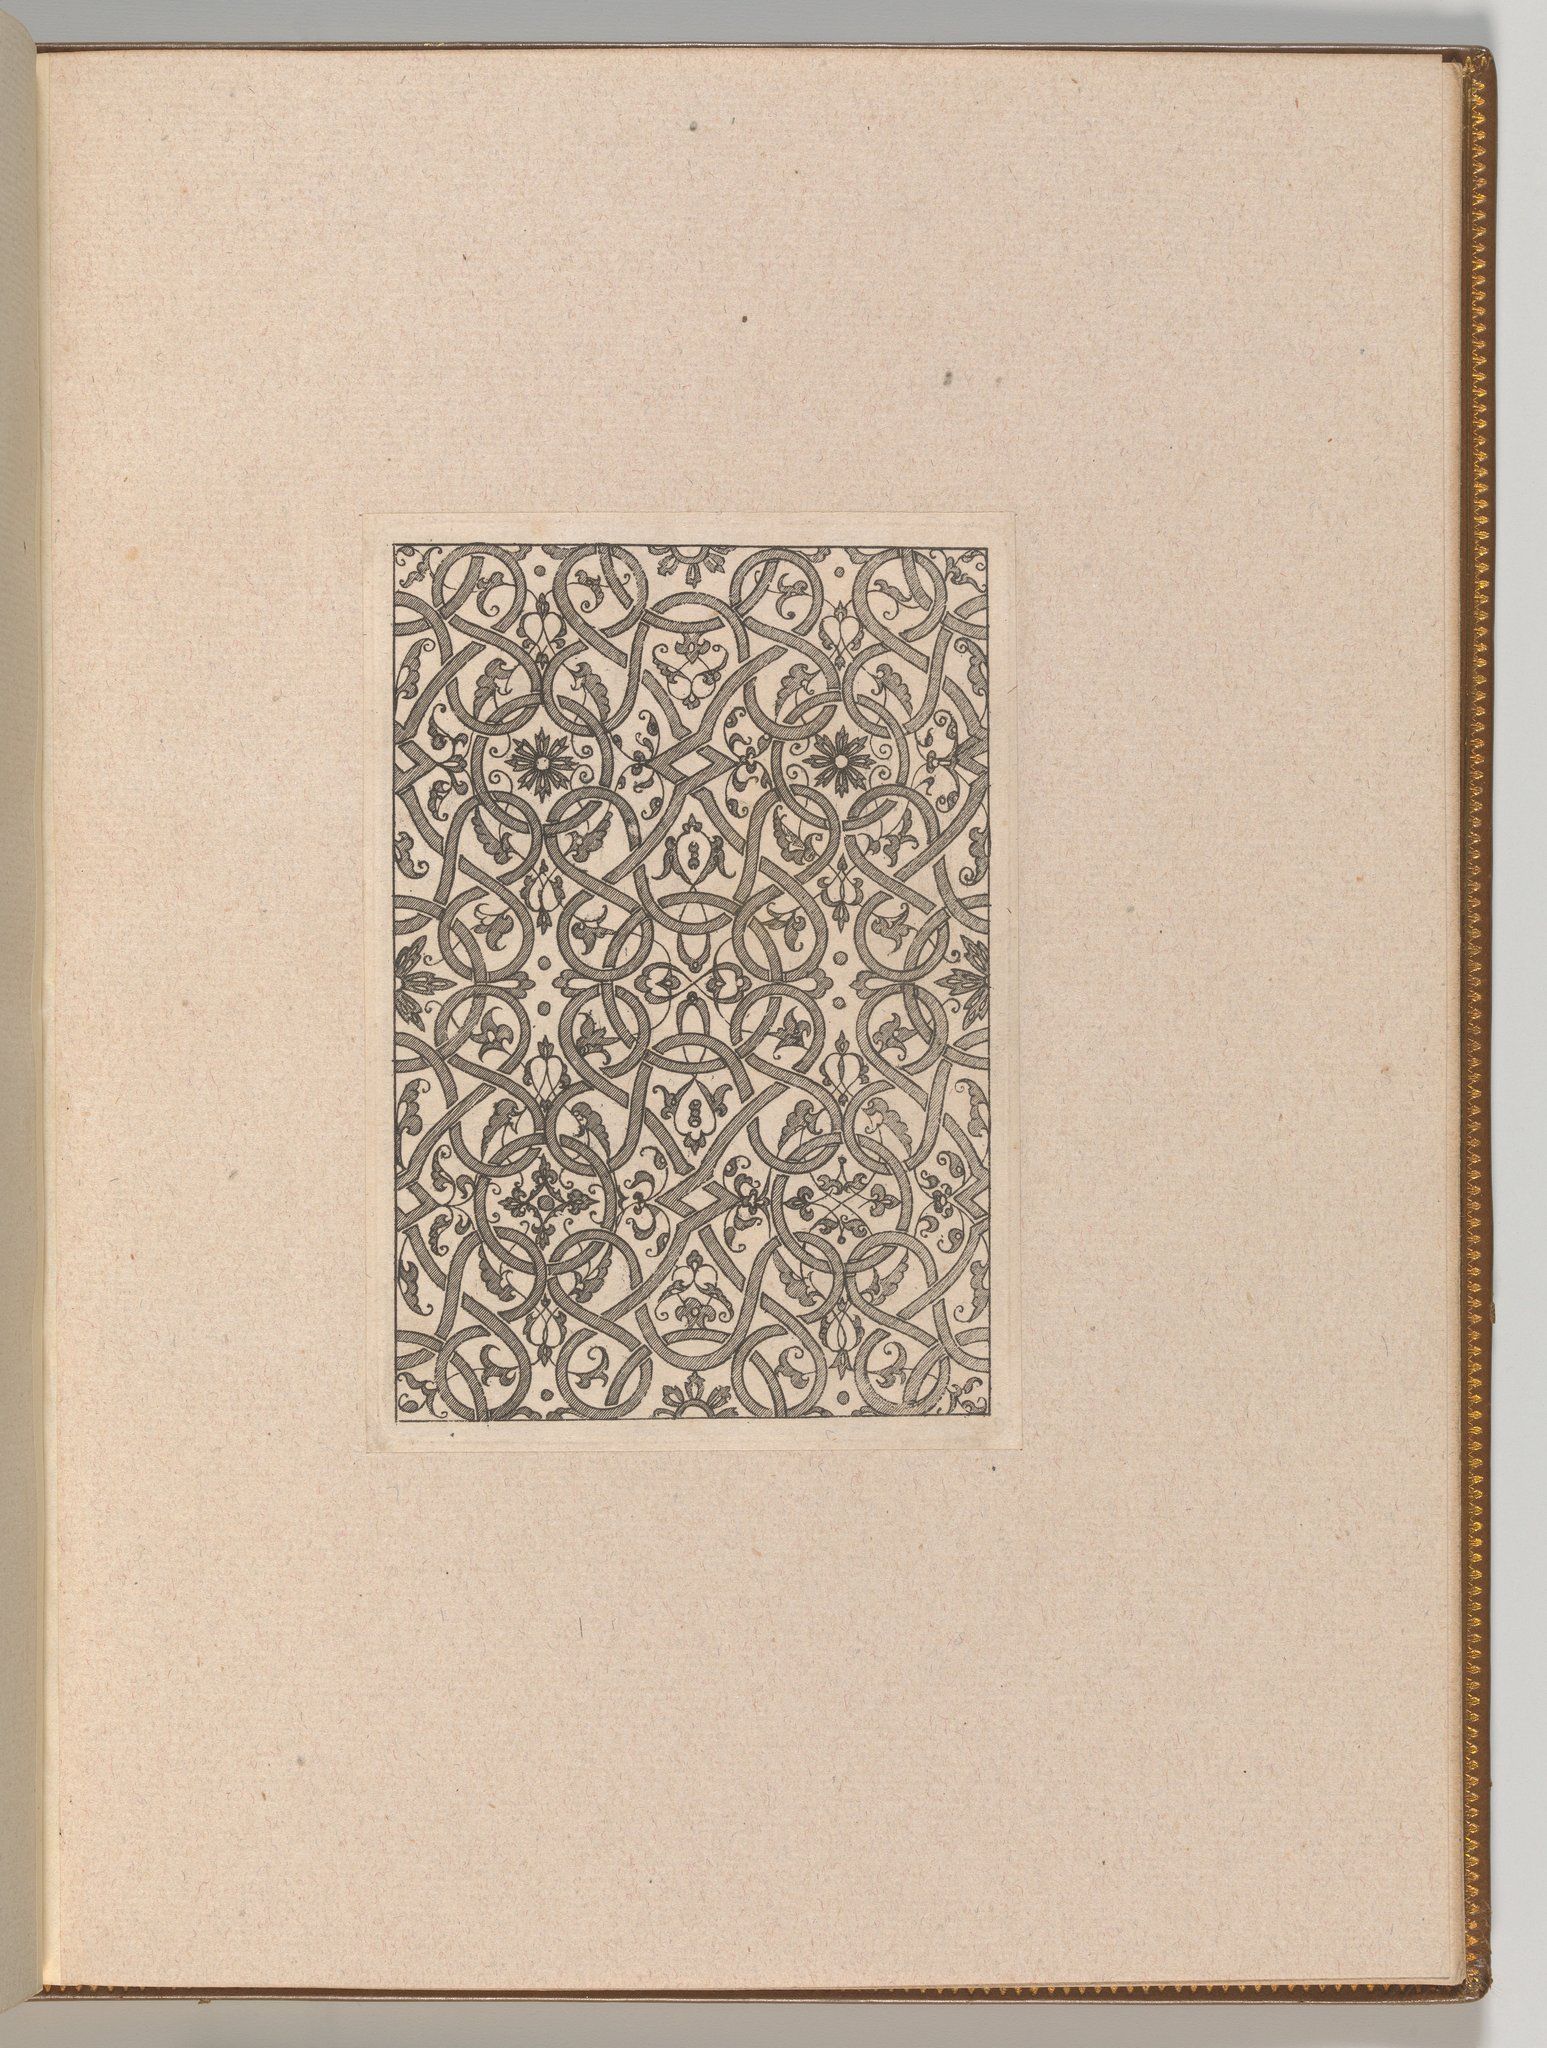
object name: album print ornament architecture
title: Copies after the 'Livre contenant passement de moresques' (plate 19)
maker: jacques androuet du cerceau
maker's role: artist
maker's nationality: french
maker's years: 1510-1585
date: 1801-1900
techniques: etching